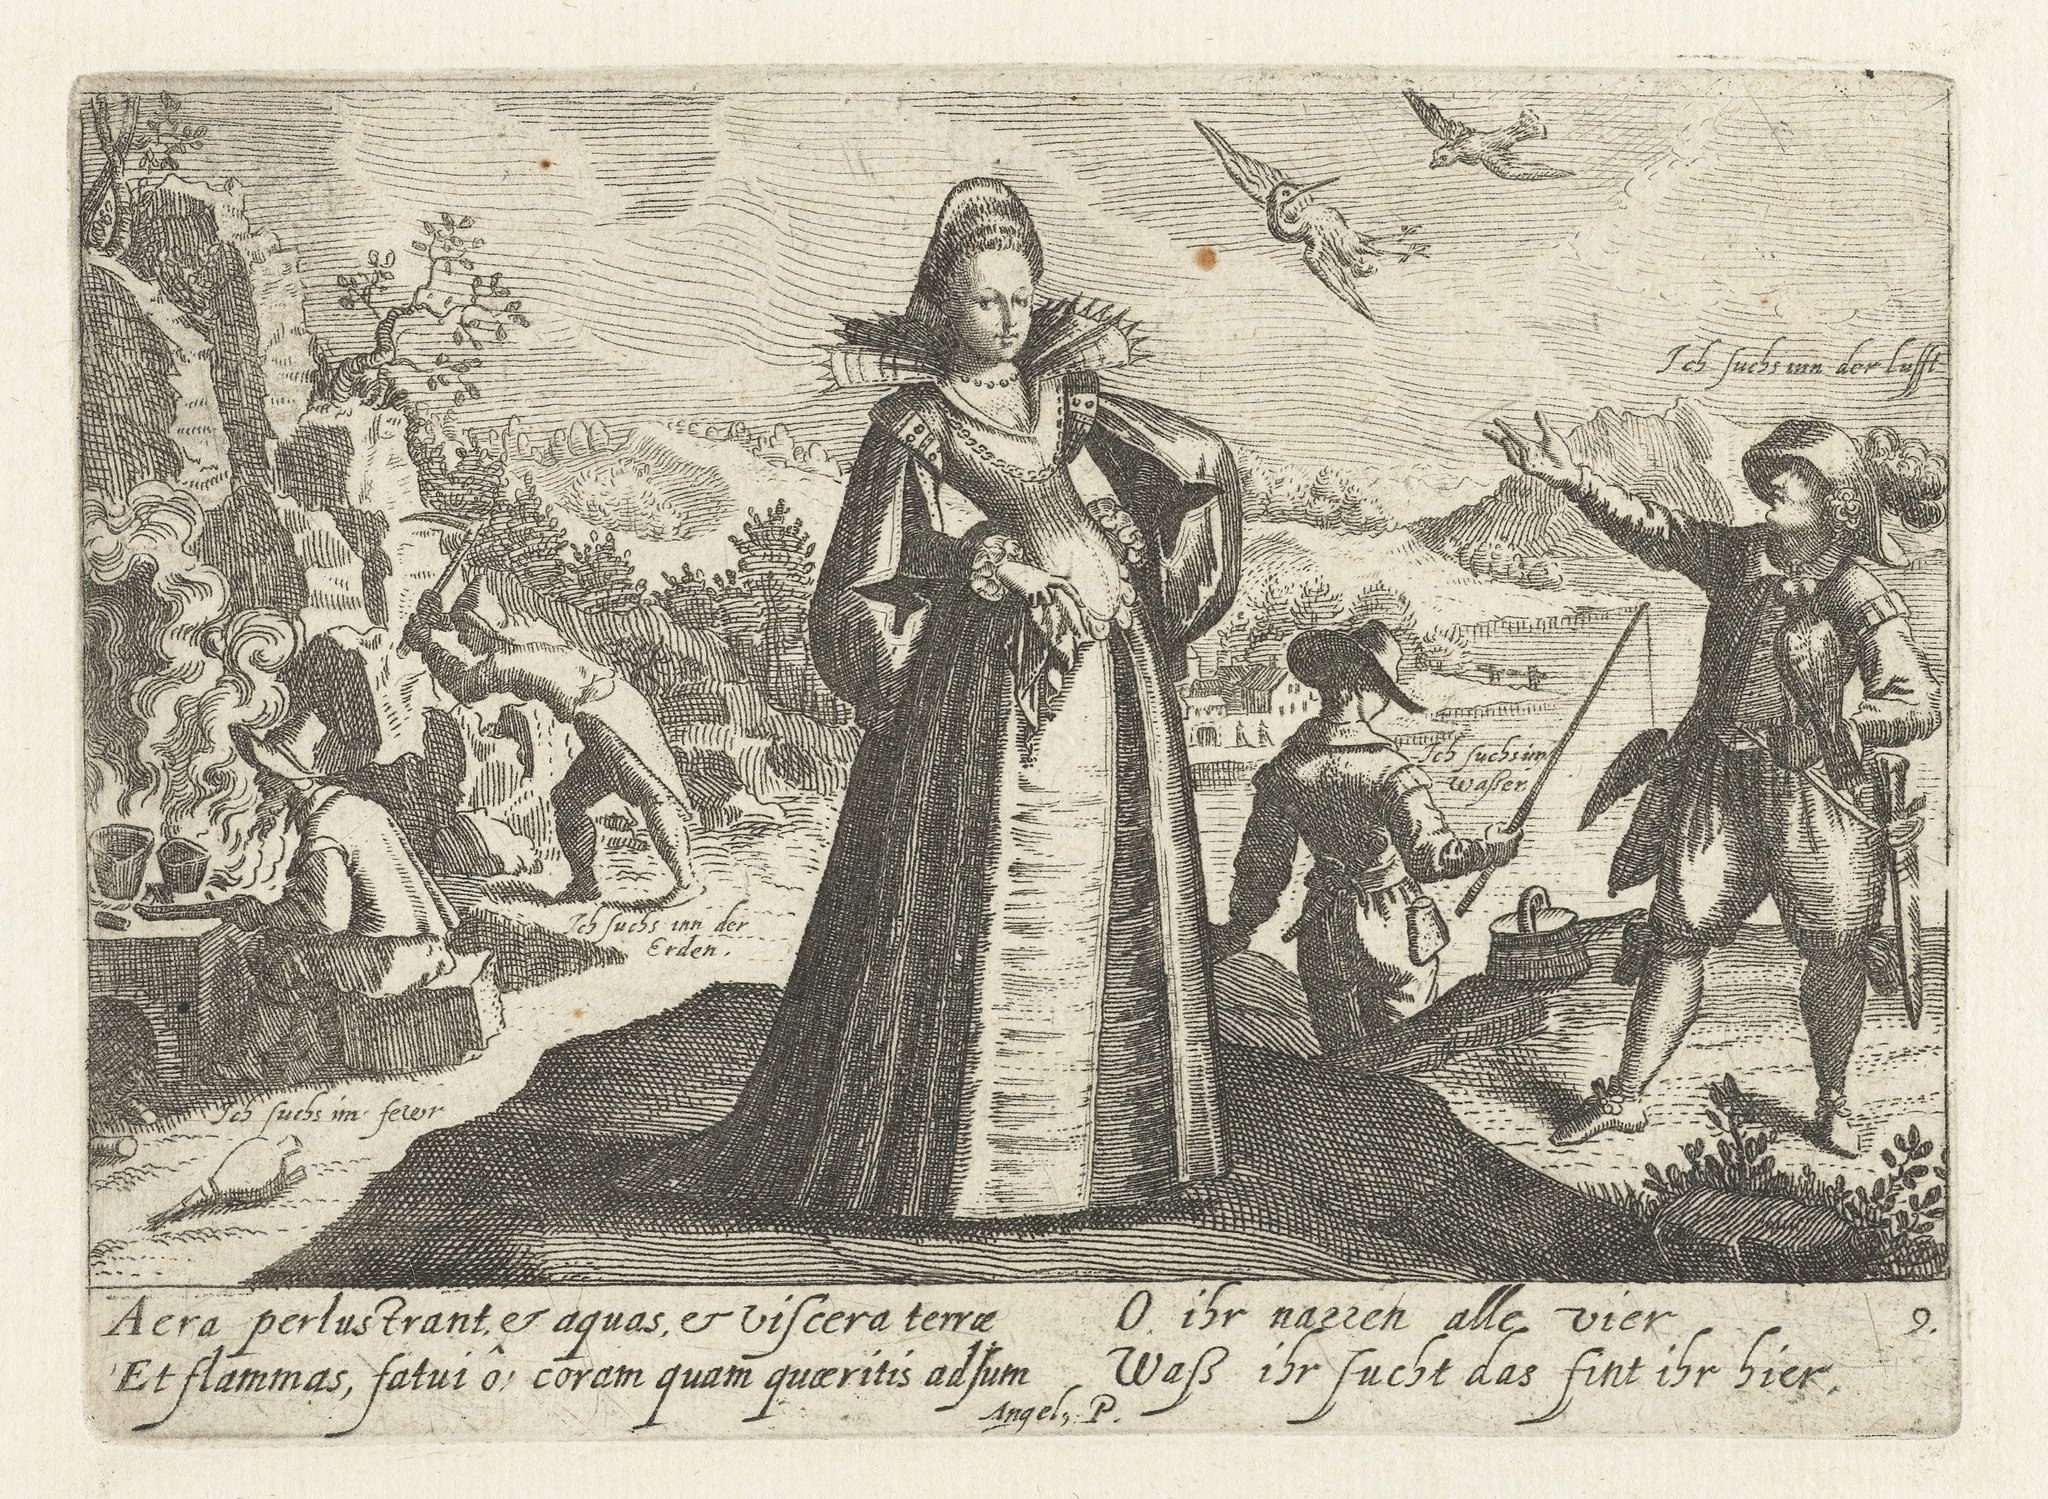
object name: print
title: Landschap met een vrouw, staand tussen vier mannen die geen oog voor haar hebben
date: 1608-1618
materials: paper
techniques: engraving, etching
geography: straatsburg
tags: predatory birds: falcon (+ man and animal), 'album amicorum', 'stammbuch', morality, smith, blacksmith, tools, aids, implements ~ crafts and industries: pickaxe, fisherman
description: Deze serie, getiteld ‘Pugillus facetiarum iconographicarum in studiosorum (…)’, bestond vermoedelijk uit 36 of meer prenten. Van deze serie zijn in ieder geval twee uitgaven bekend, uit 1608 en 1618. De prenten uit deze serie in de collectie van het Rijksmuseum (RP-P-1996-1 t/m RP-P-1996-36) zijn vermoedelijk afkomstig uit verschillende uitgaven, of uit de tweede uitgave. De inhoud van beide uitgaven verschilt, maar om de precieze inhoud van de verschillende uitgaven vast te stellen is meer onderzoek nodig. Er zijn geen volledige exemplaren van de eerste uitgave bekend. Aan de hand van de analyse van een andere serie, ‘Jeucht spieghel’,* die kopieën van ‘Pugillus’ bevat en is uitgegeven in 1610 én de aanwezige exemplaren van prenten uit ‘Pugillus’ in een inmiddels verloren album amicorum uit 1610,** kan in ieder geval van een aantal prenten gesteld worden dat ze al voorkwamen in de uitgave van 1608. Dit geldt voor RP-P-1996-1 (de titelprent), RP-P-1996-5, RP-P-1996-6, RP-P-1996-7, RP-P-1996-8, RP-P-1996-9, RP-P-1996-10, RP-P-1996-11, RP-P-1996-12, RP-P-1996-13, RP-P-1996-14, RP-P-1996-15, RP-P-1996-16, RP-P-1996-17, RP-P-1996-18, RP-P-1996-19, RP-P-1996-24, RP-P-1996-28, RP-P-1996-29, RP-P-1996-33 en RP-P-1996-35. Van één prent (RP-P-1996-31) kan vastgesteld worden dat die pas in de latere uitgave van 1618 voorkwam, omdat het kopie is van een prent uit weer een andere serie, ‘Academia sive speculum vitae scholasticae (…)’, die werd uitgegeven in 1612.*** Deze prent kwam al voor in de uitgave van 1608. Dit blijkt uit ‘Jeucht spieghel’.* * Z.G.H.P.H.S [Zacharias Heyns]. Jeucht spieghel. S.l.s.n., 1610. Voor een gedigitaliseerd exemplaar zie: https://archive.org/details/ned-kbn-all-00000628-001/page/n9/mode/2up. ** Zie: Erman, Wilhelm en Ewald Horn. Bibliographie der deutschen Universitäten, systematisch geordnetes Verzeichnis der bis Ende 1899 gedruckten Bücher und Aufsätze über das deutsche Universitätswesen. Leipzig en Berlijn: Verlag von B.G. Teubner, 1904, dl. 1, p. 826-832, no. 17328. https://archive.org/details/bibliographieder01ermauoft/page/826/mode/2up *** Passe, Crispijn van de (I). Academia sive speculum vitae scholasticae (…). Arnhem: Johannes Janssonius [Jan Jansz.], 1612. Voor een gedigitaliseerd exemplaar zie: http://gallica.bnf.fr/ark:/12148/btv1b55005974h.